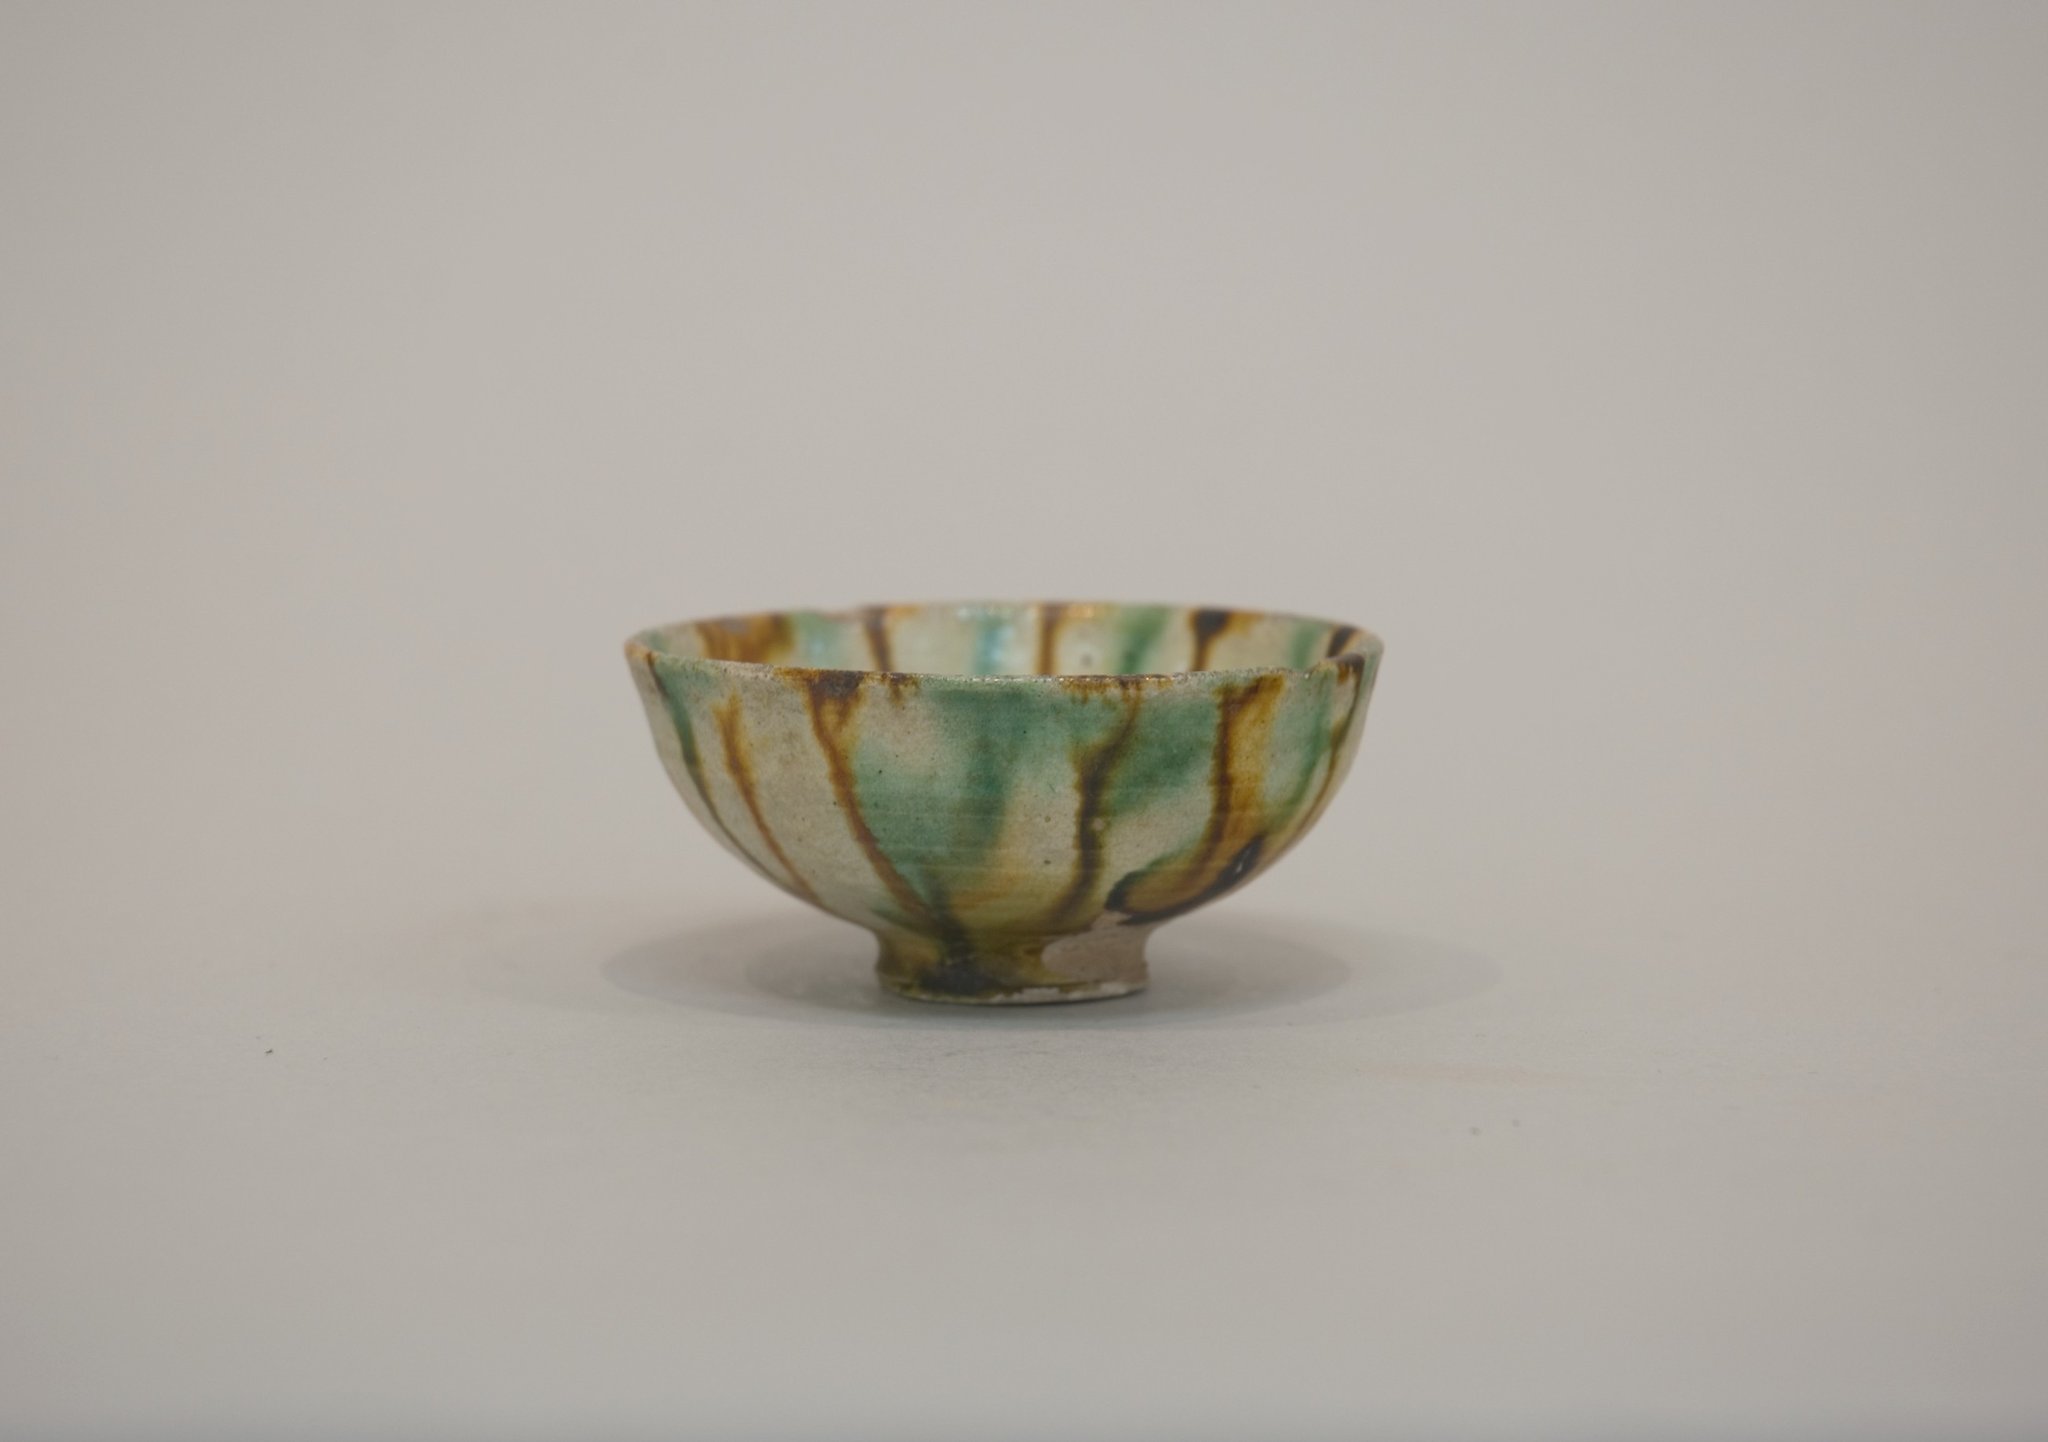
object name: bowl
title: Miniature bowl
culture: chinese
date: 701-800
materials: earthenware, glaze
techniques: polychrome